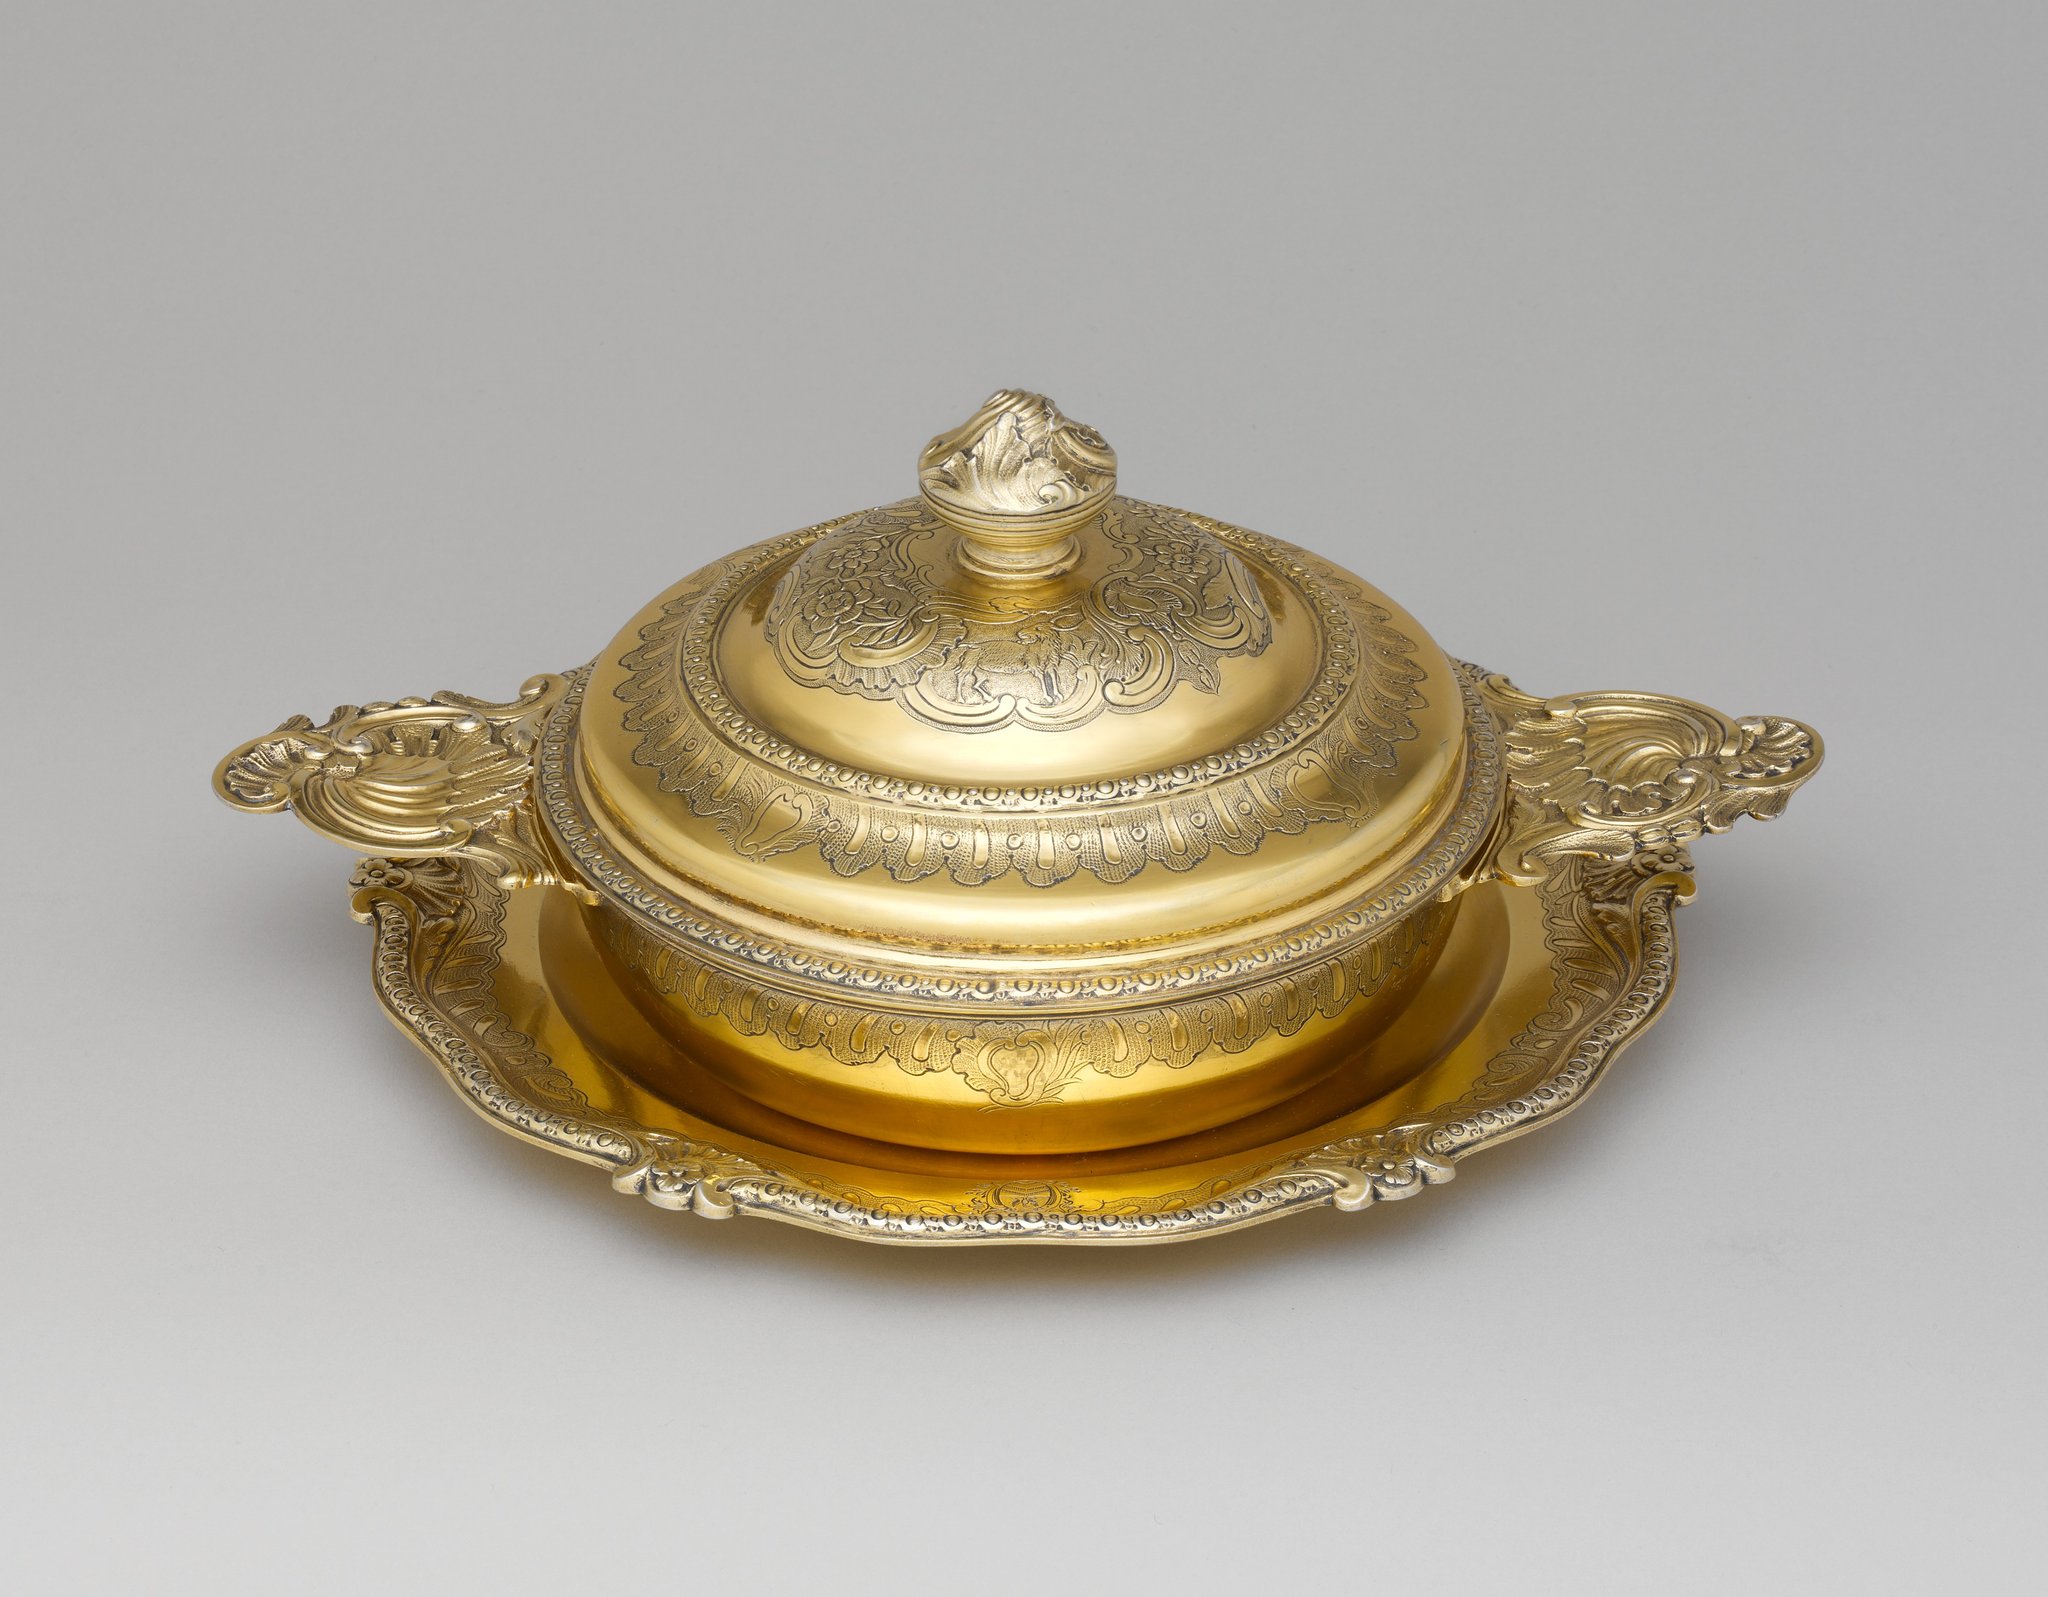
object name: plate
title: Plate (part of a traveling set)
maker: joachim-frédéric kirstein i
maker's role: maker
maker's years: 1729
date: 1750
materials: silver